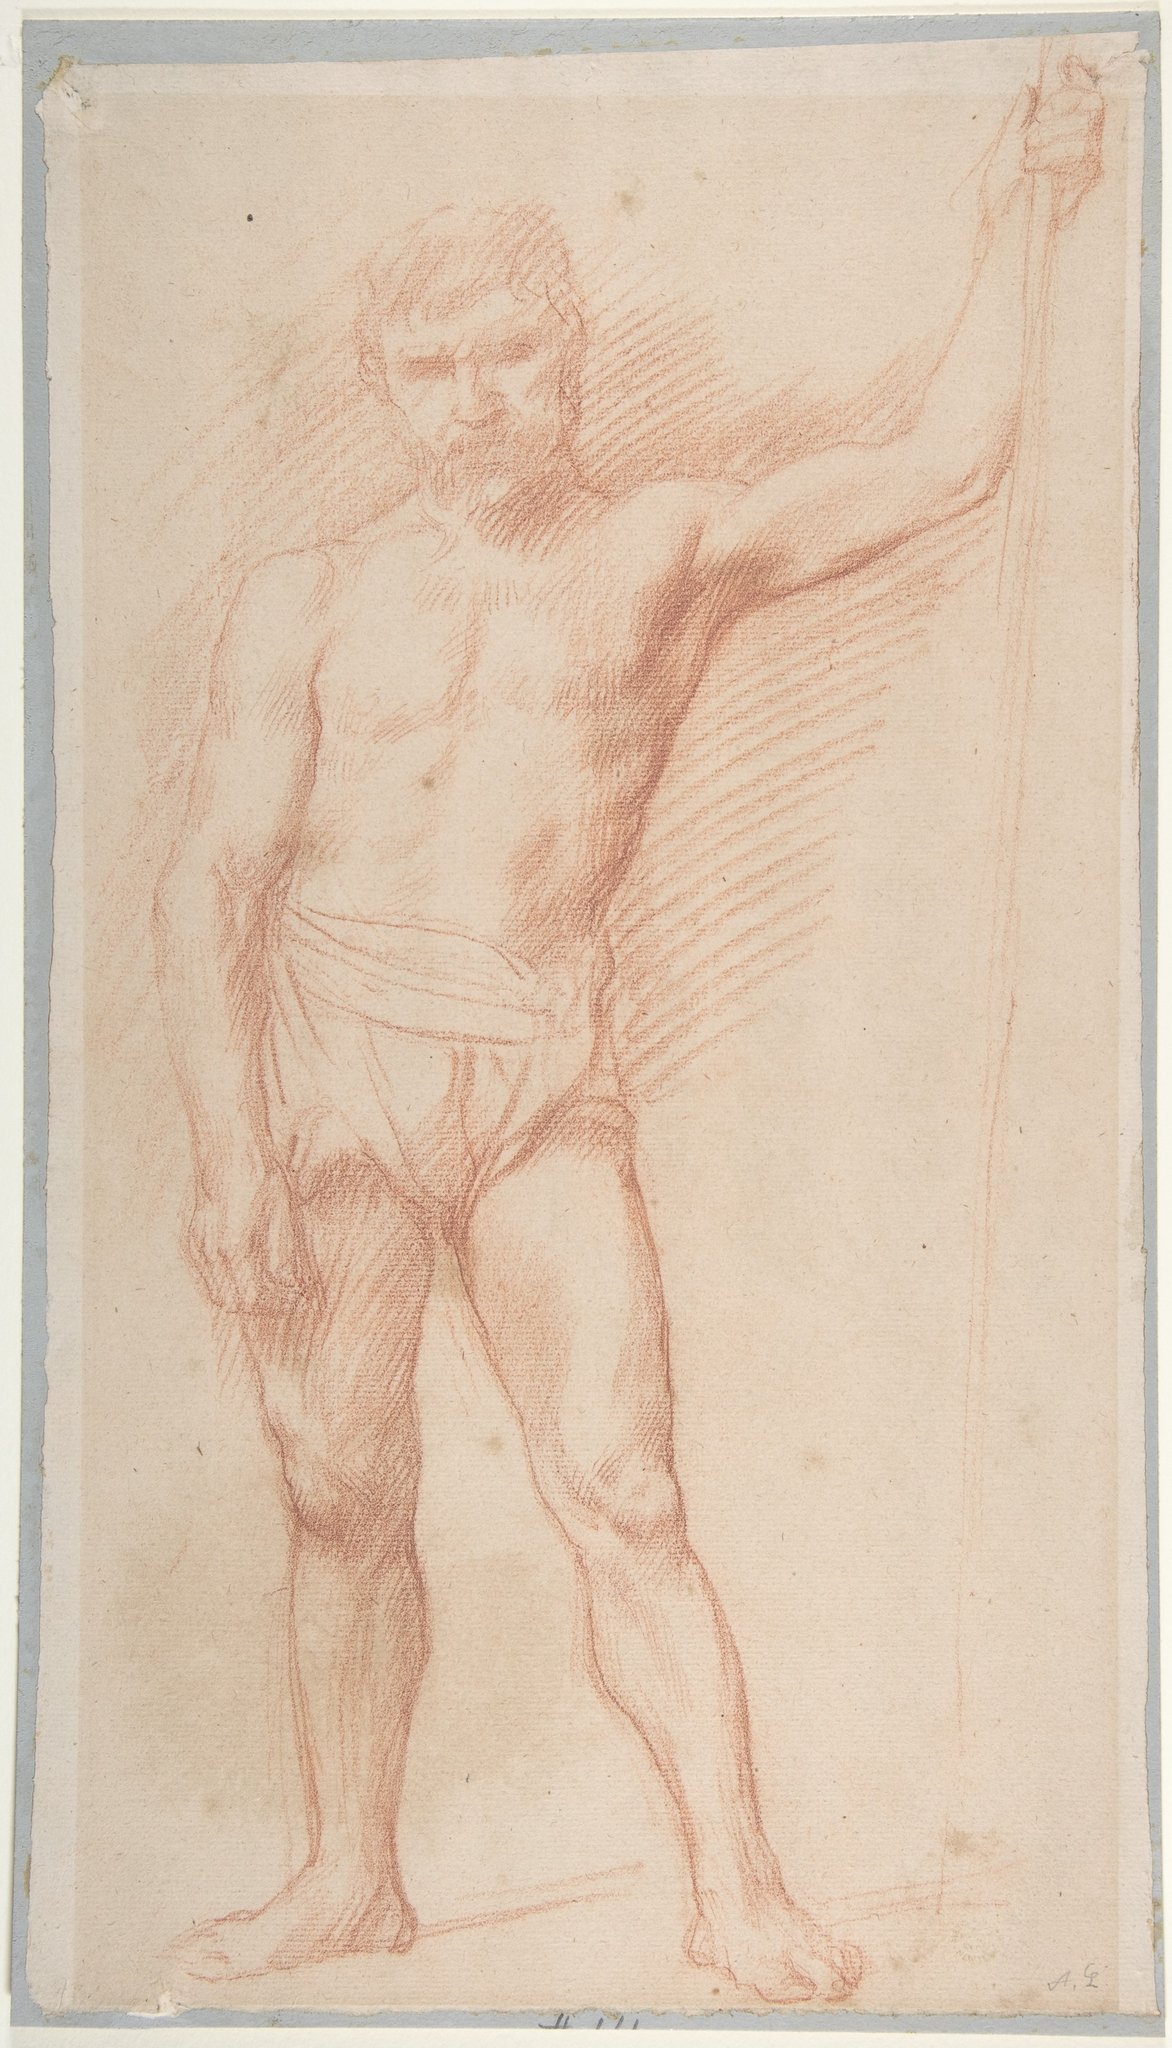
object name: drawing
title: Study of a Figure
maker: alphonse legros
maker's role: artist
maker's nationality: french and british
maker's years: 1837-1911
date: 1837-1911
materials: chalk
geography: france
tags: men